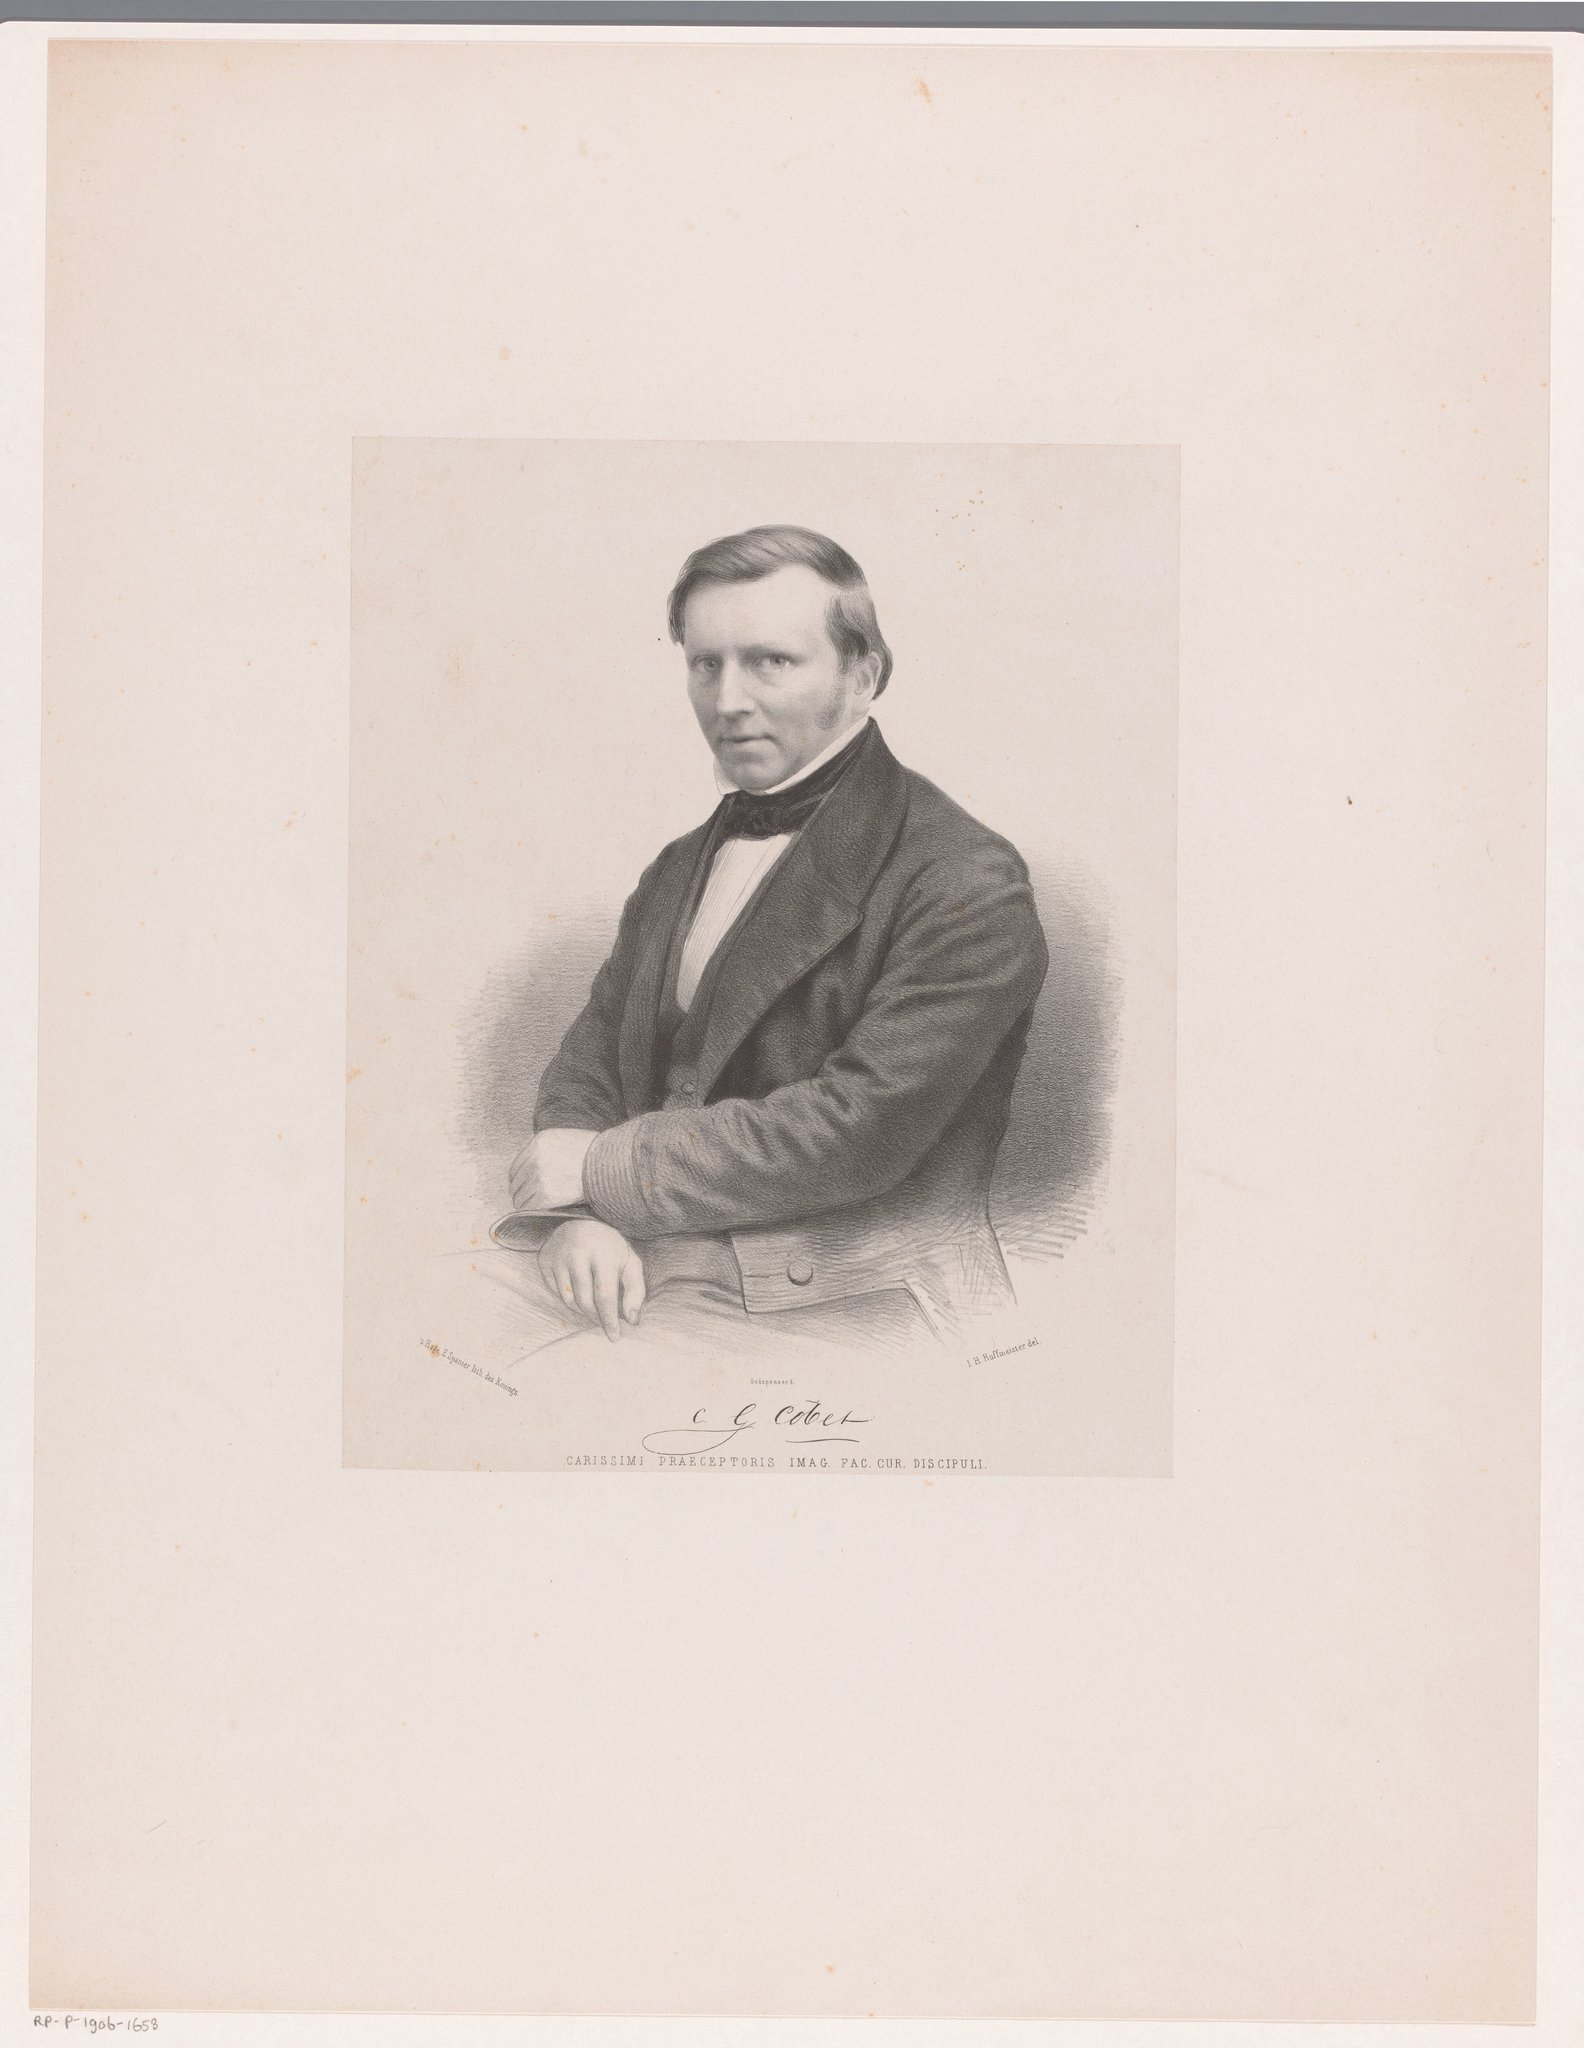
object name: print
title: Portret van Carel Gabriel Cobet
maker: johan hendrik hoffmeister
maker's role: print maker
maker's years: 1823-1904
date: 1851-1883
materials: paper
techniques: lithograph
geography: the hague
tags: paris, leiden, historical persons (+ half-length portrait)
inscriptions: : ‘Gedeponeerd.’, collector's mark: Lugt 2228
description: Onder het portret de signatuur van de geportretteerde.